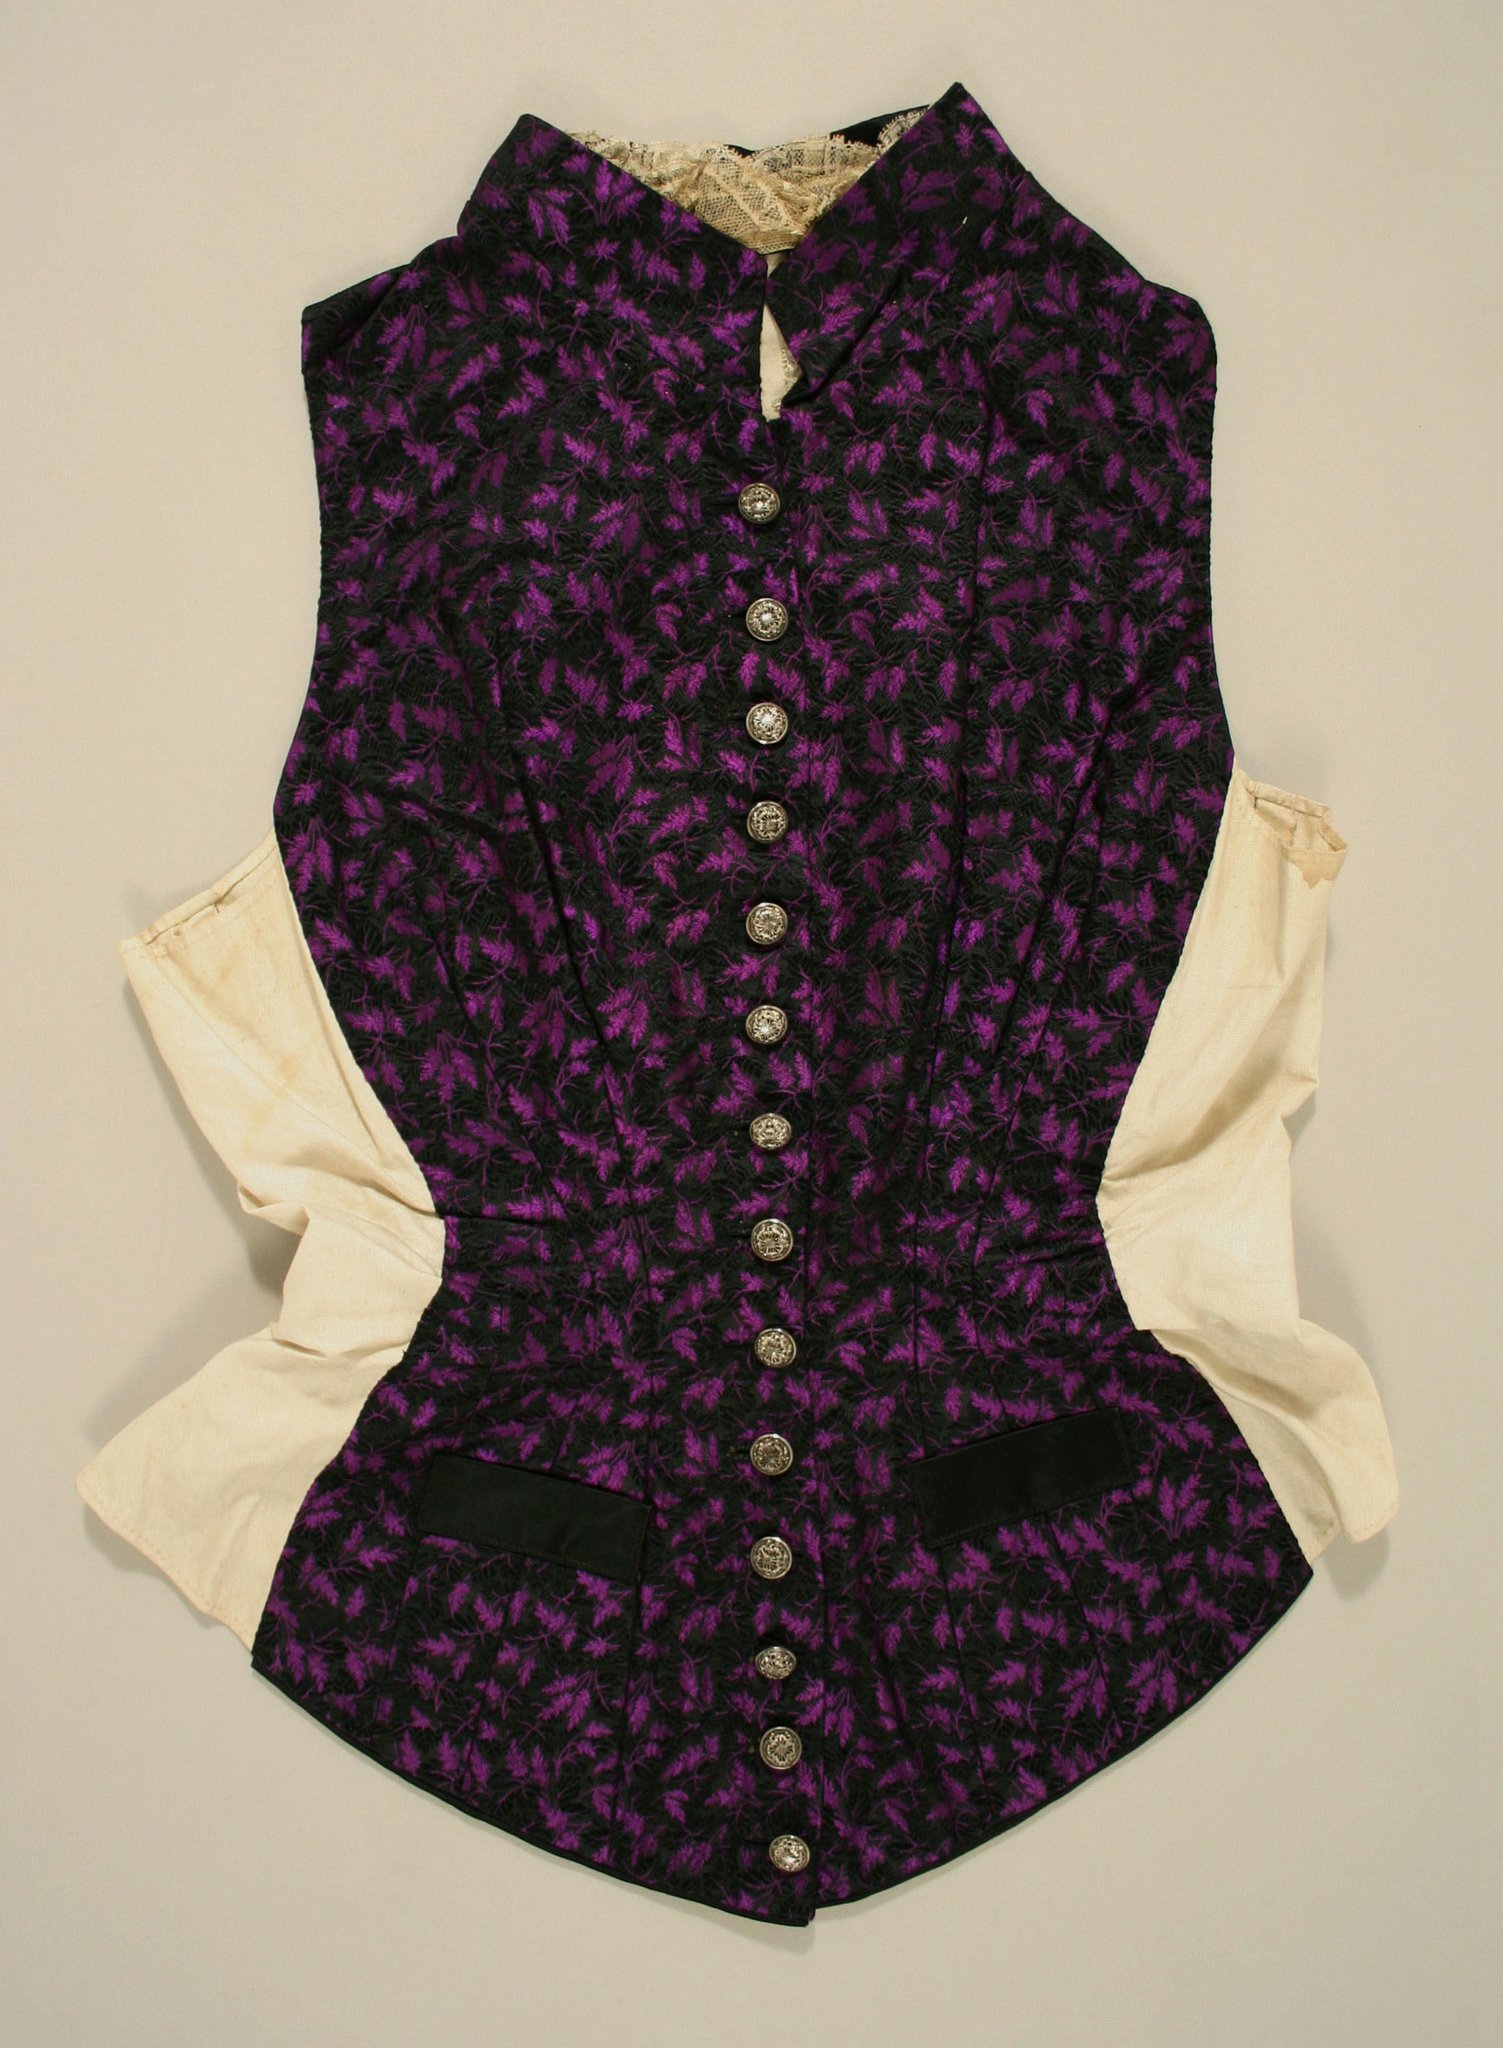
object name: vest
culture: american or european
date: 1850-1889